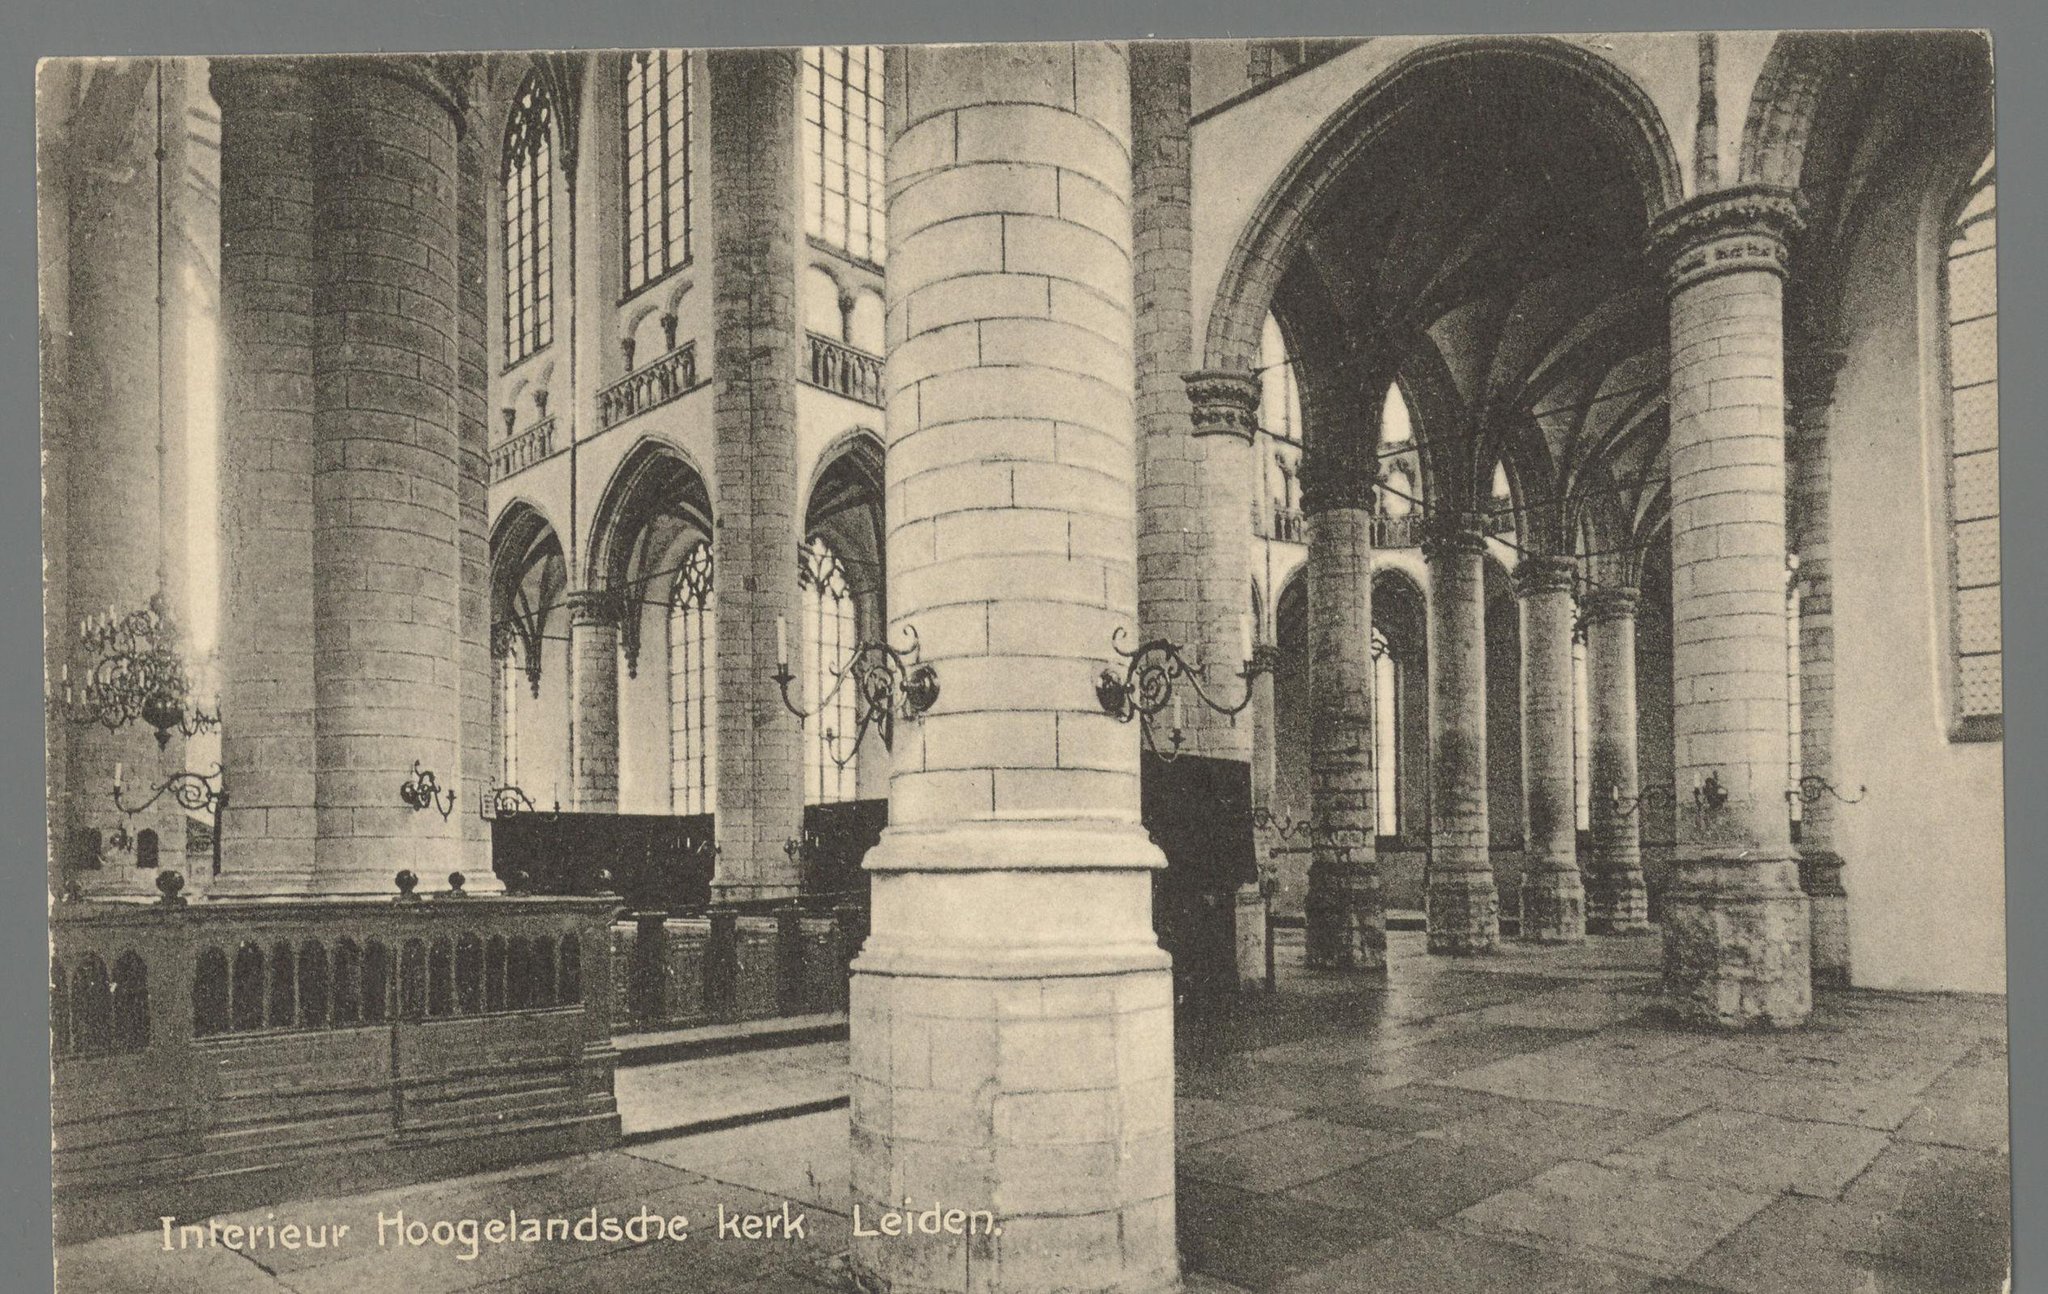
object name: ansichtkaart, prentbriefkaart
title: Interieur Hoogelandsche kerk Leiden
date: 1905-1930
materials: cardboard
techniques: photograph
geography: leiden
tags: interior of church